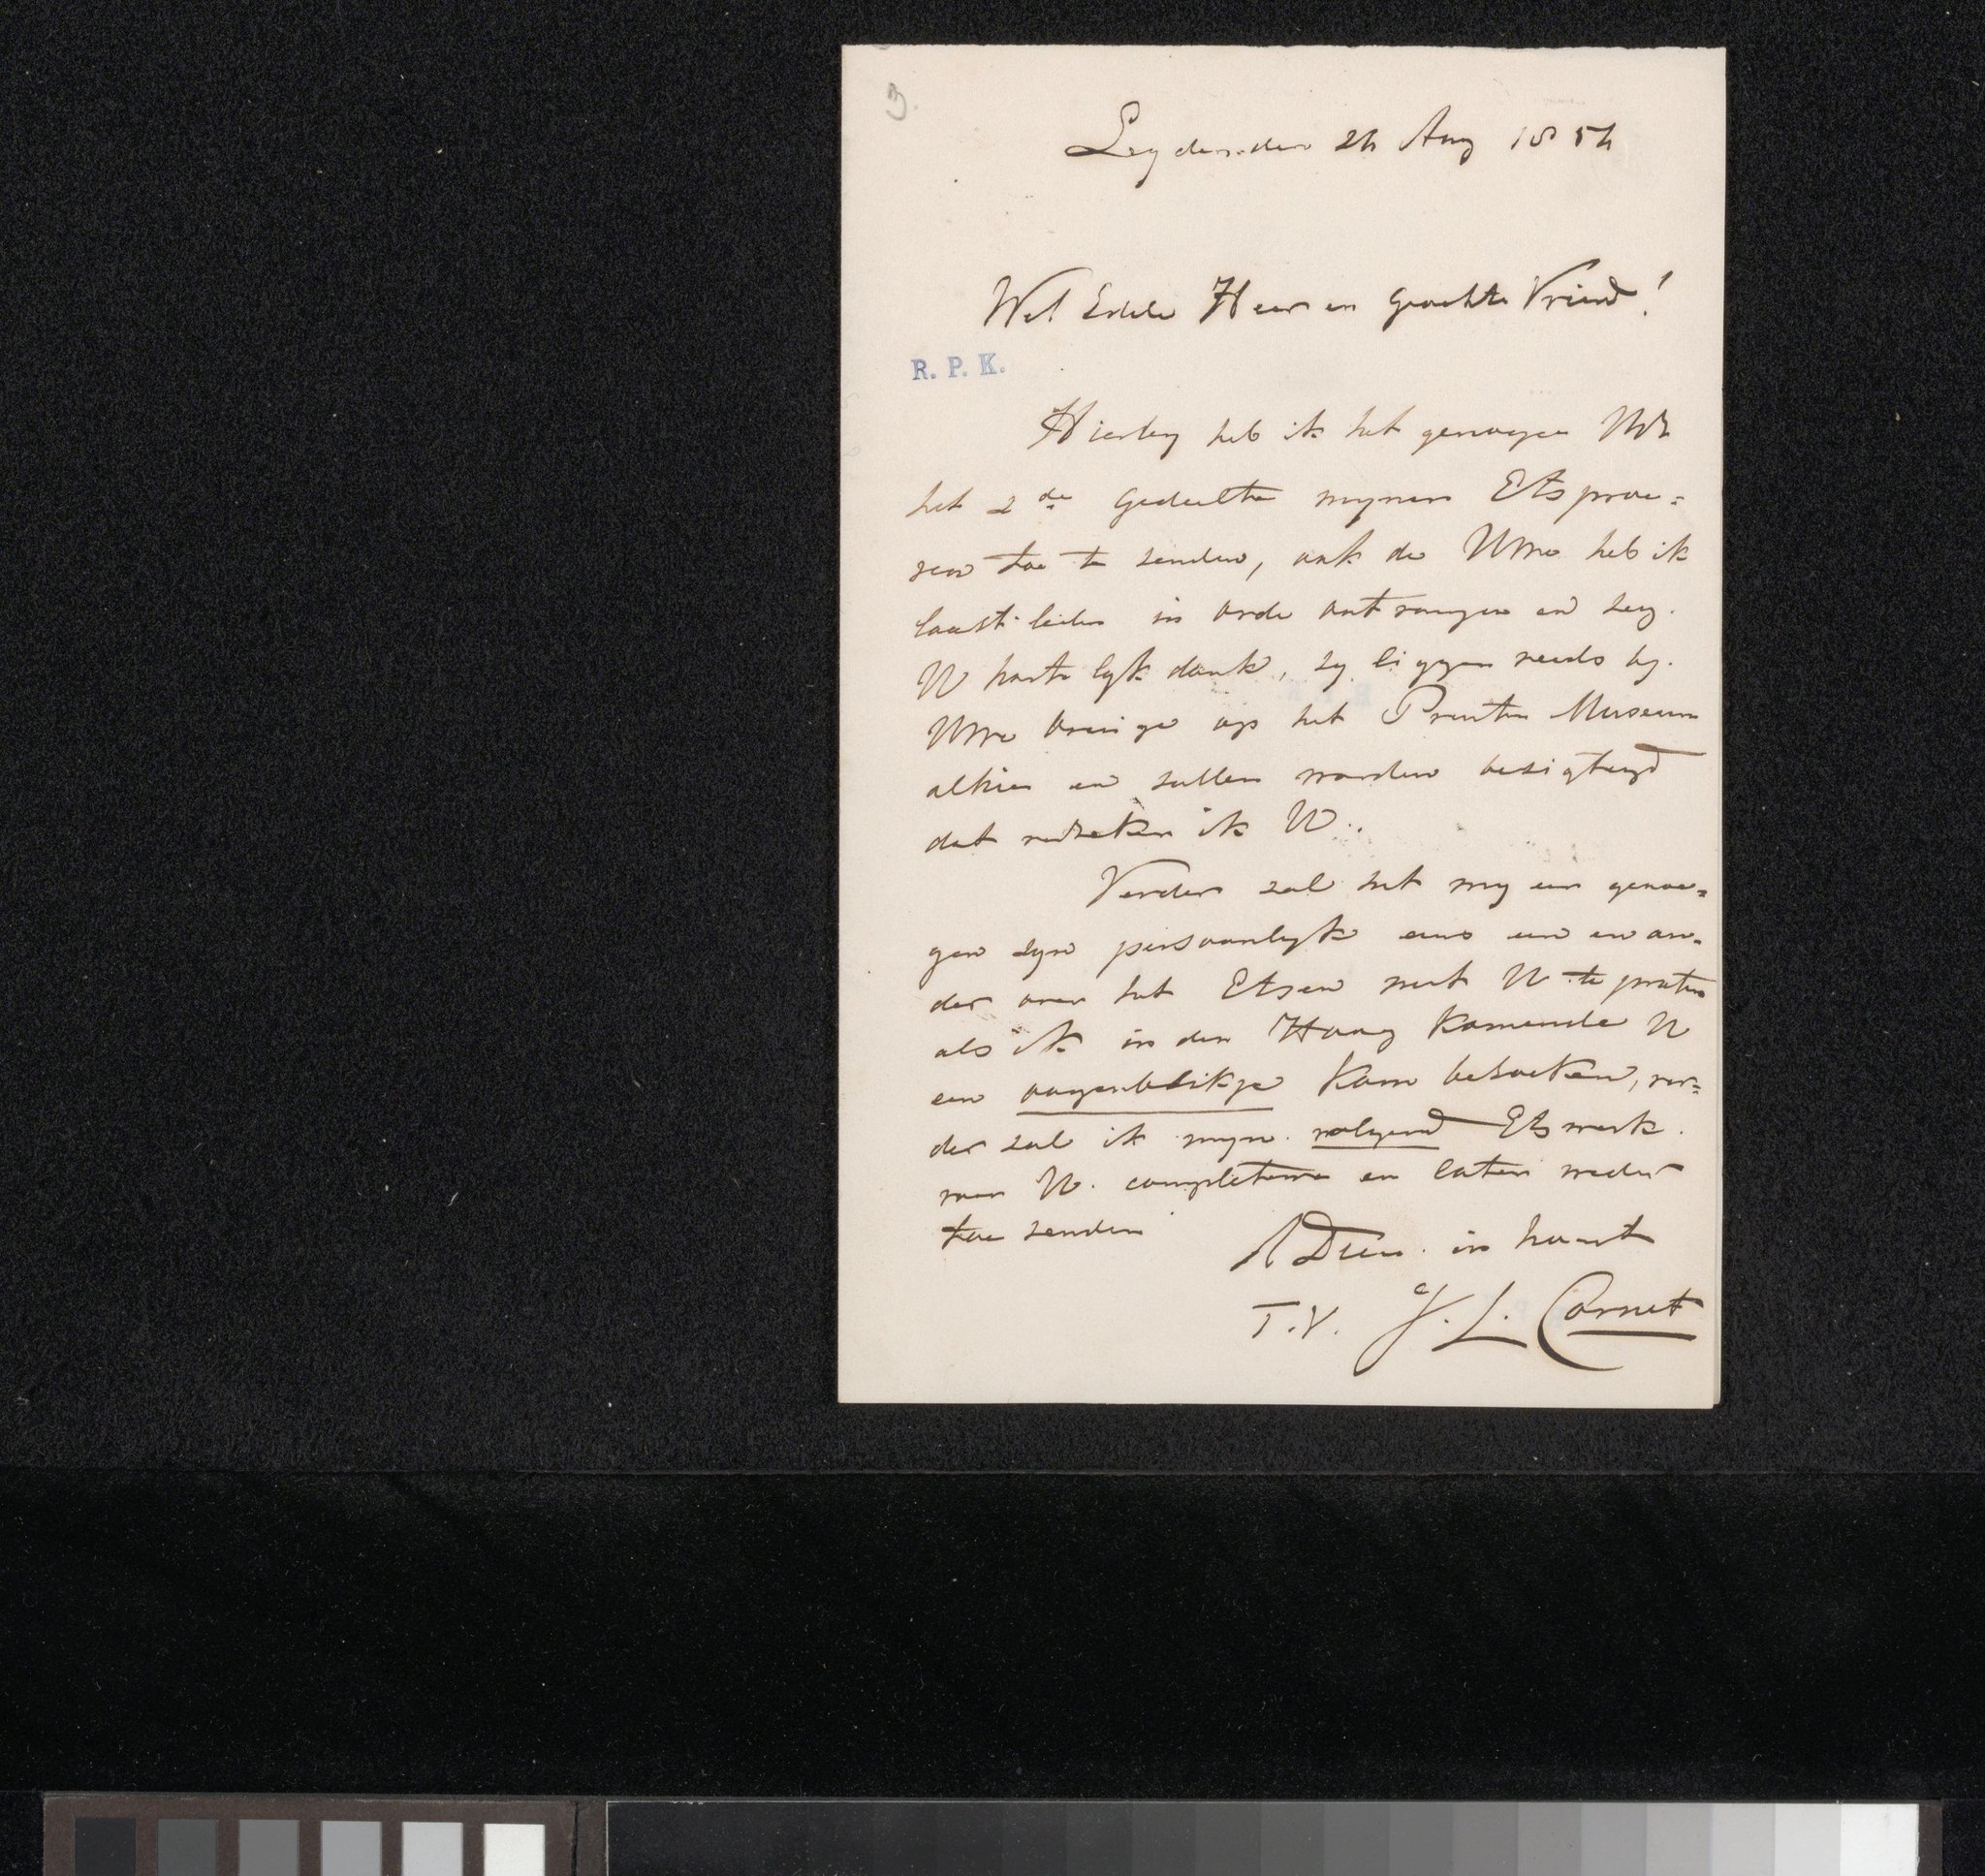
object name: letter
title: Brief aan anoniem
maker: jacobus ludovicus cornet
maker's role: draughtsman, print maker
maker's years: 1815-1882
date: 1854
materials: ink, paper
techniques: pen, writing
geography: leiden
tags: the graphic arts, the hague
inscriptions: collector's mark: Lugt 2233